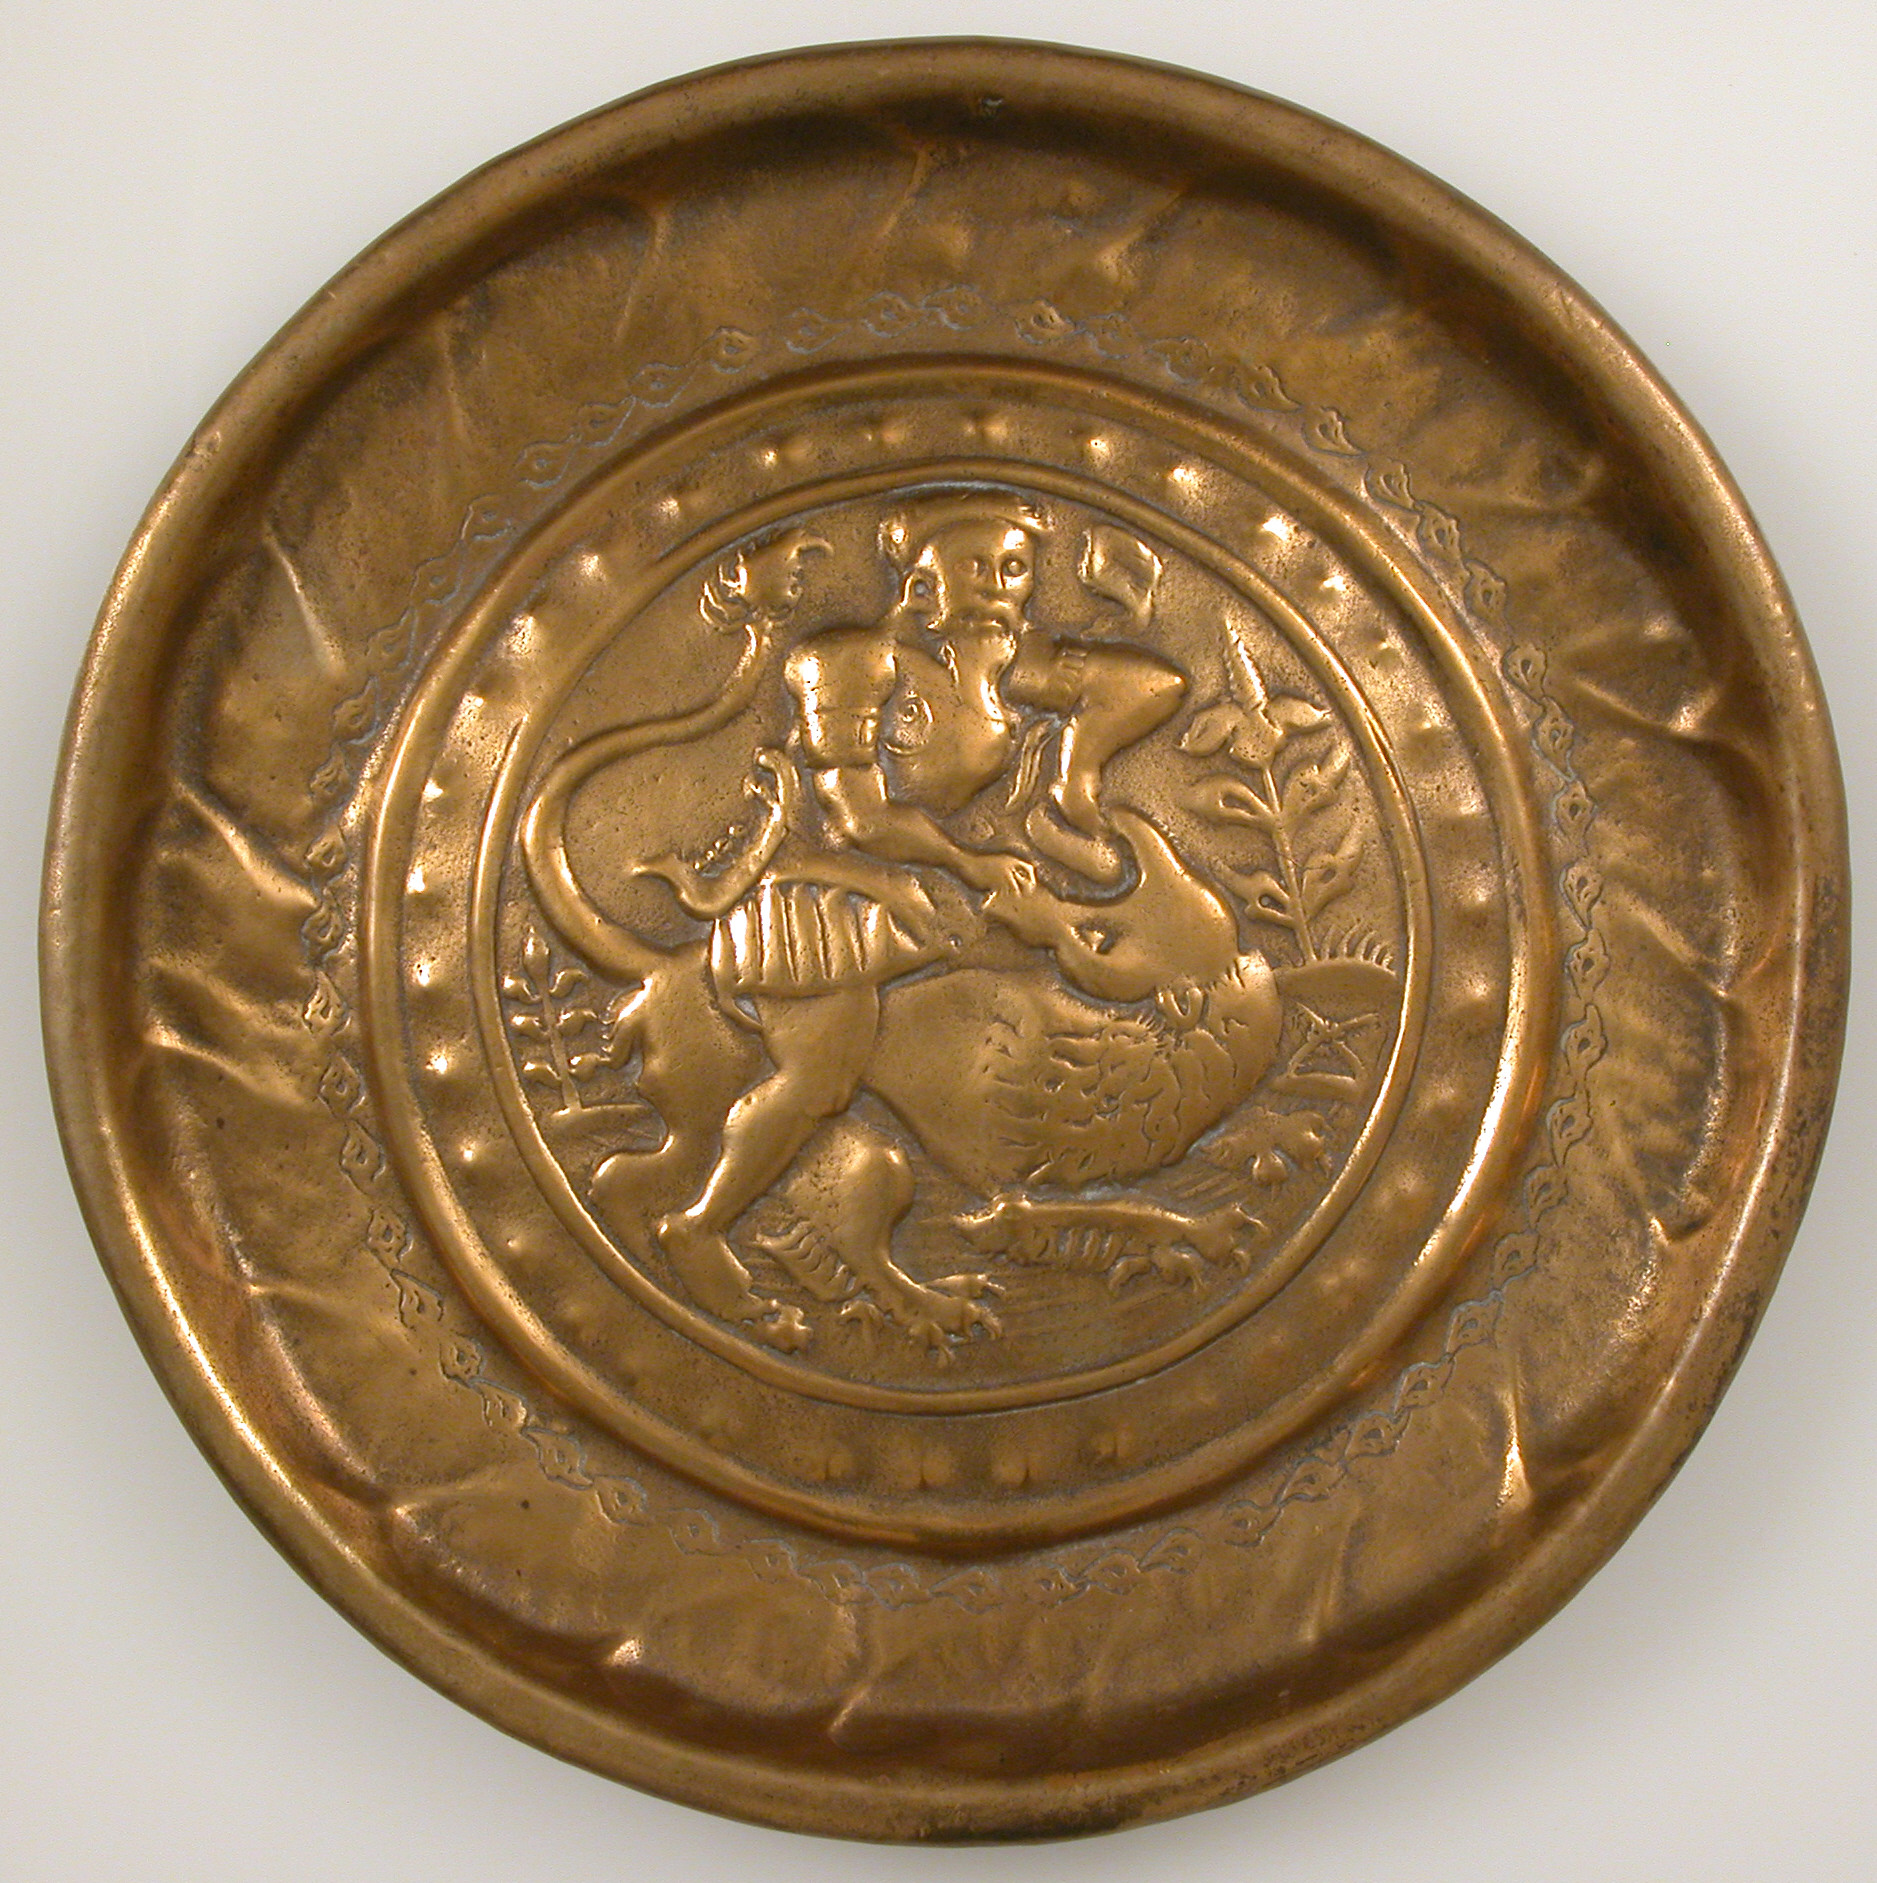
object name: dish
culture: german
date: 1501-1533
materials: brass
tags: lions,samson